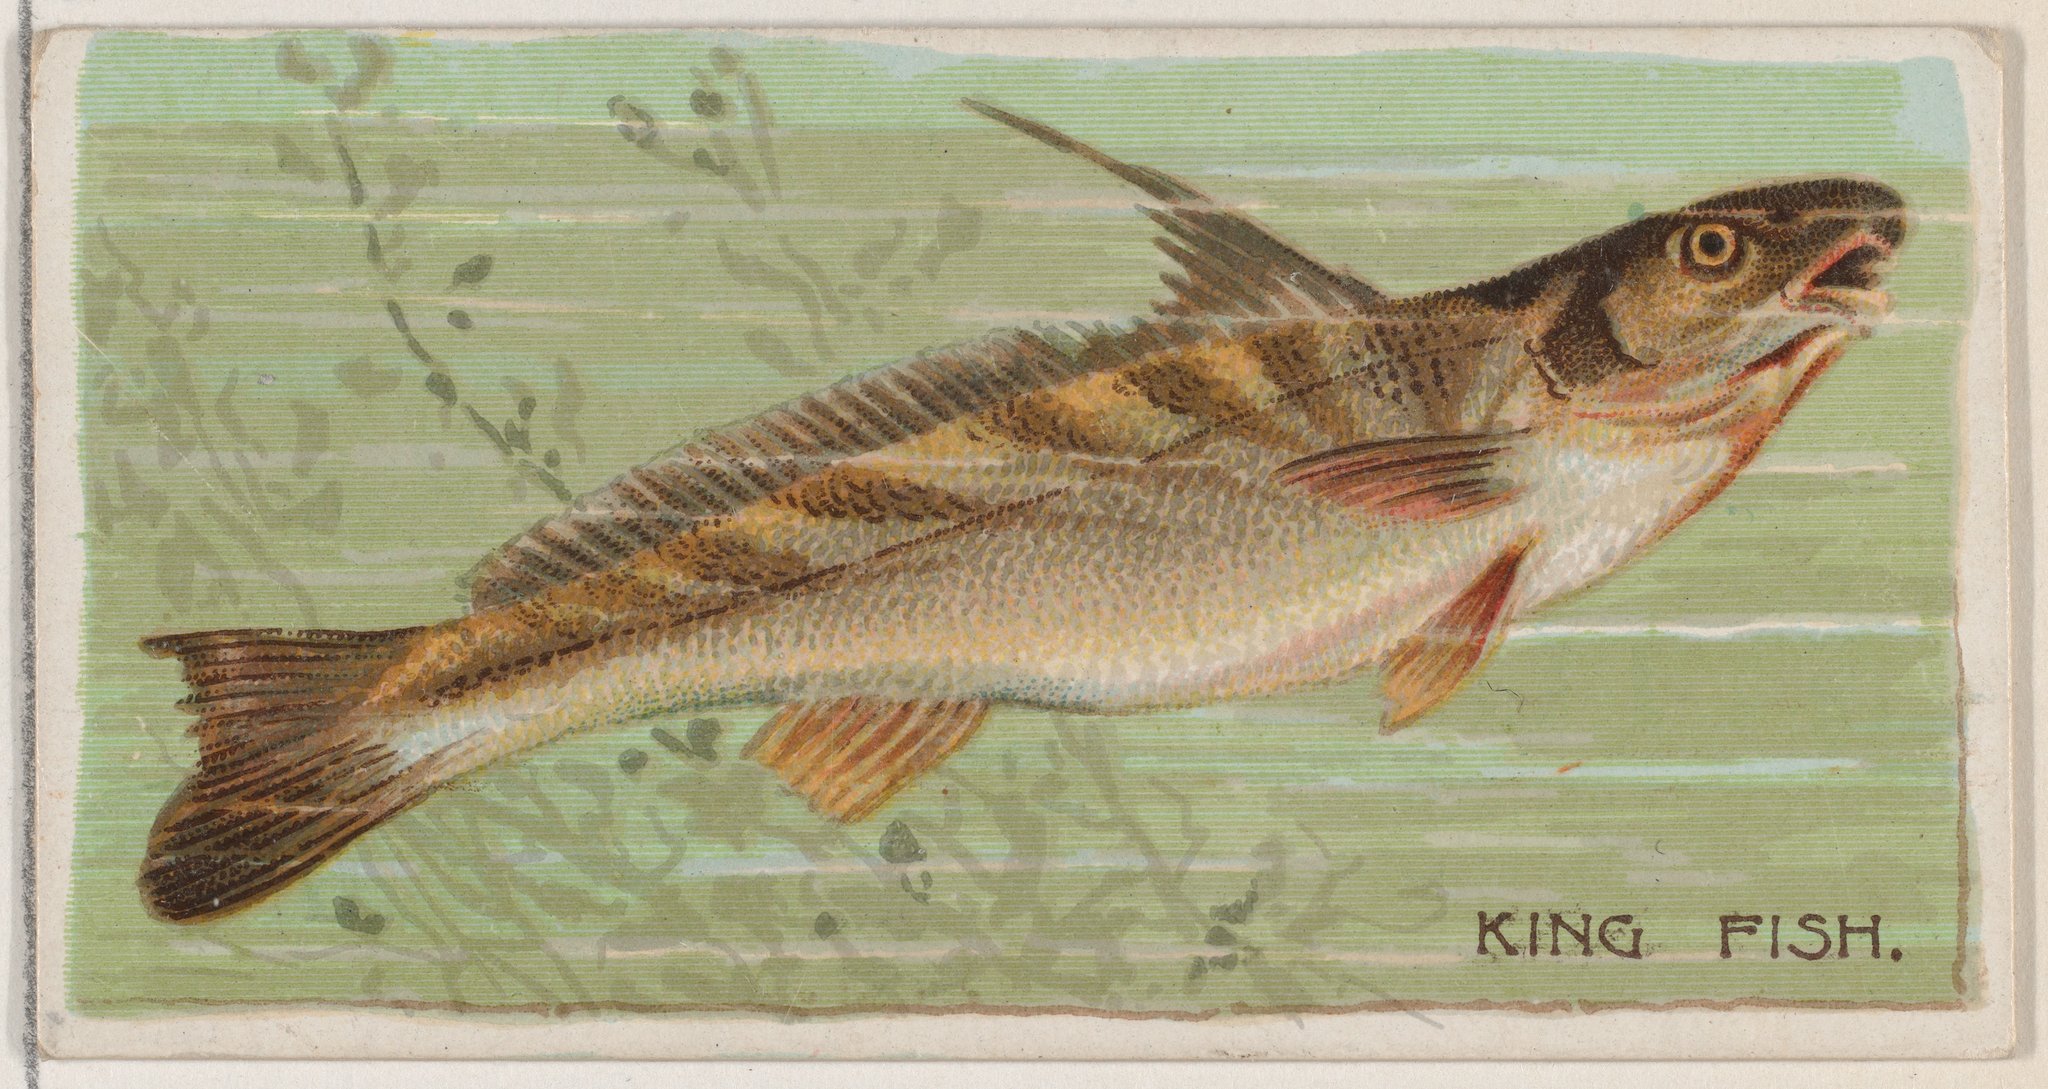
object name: print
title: King Fish, from the series Fishers and Fish (N74) for Duke brand cigarettes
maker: knapp & company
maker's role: lithographer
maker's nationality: american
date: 1888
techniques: color lithograph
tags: fish